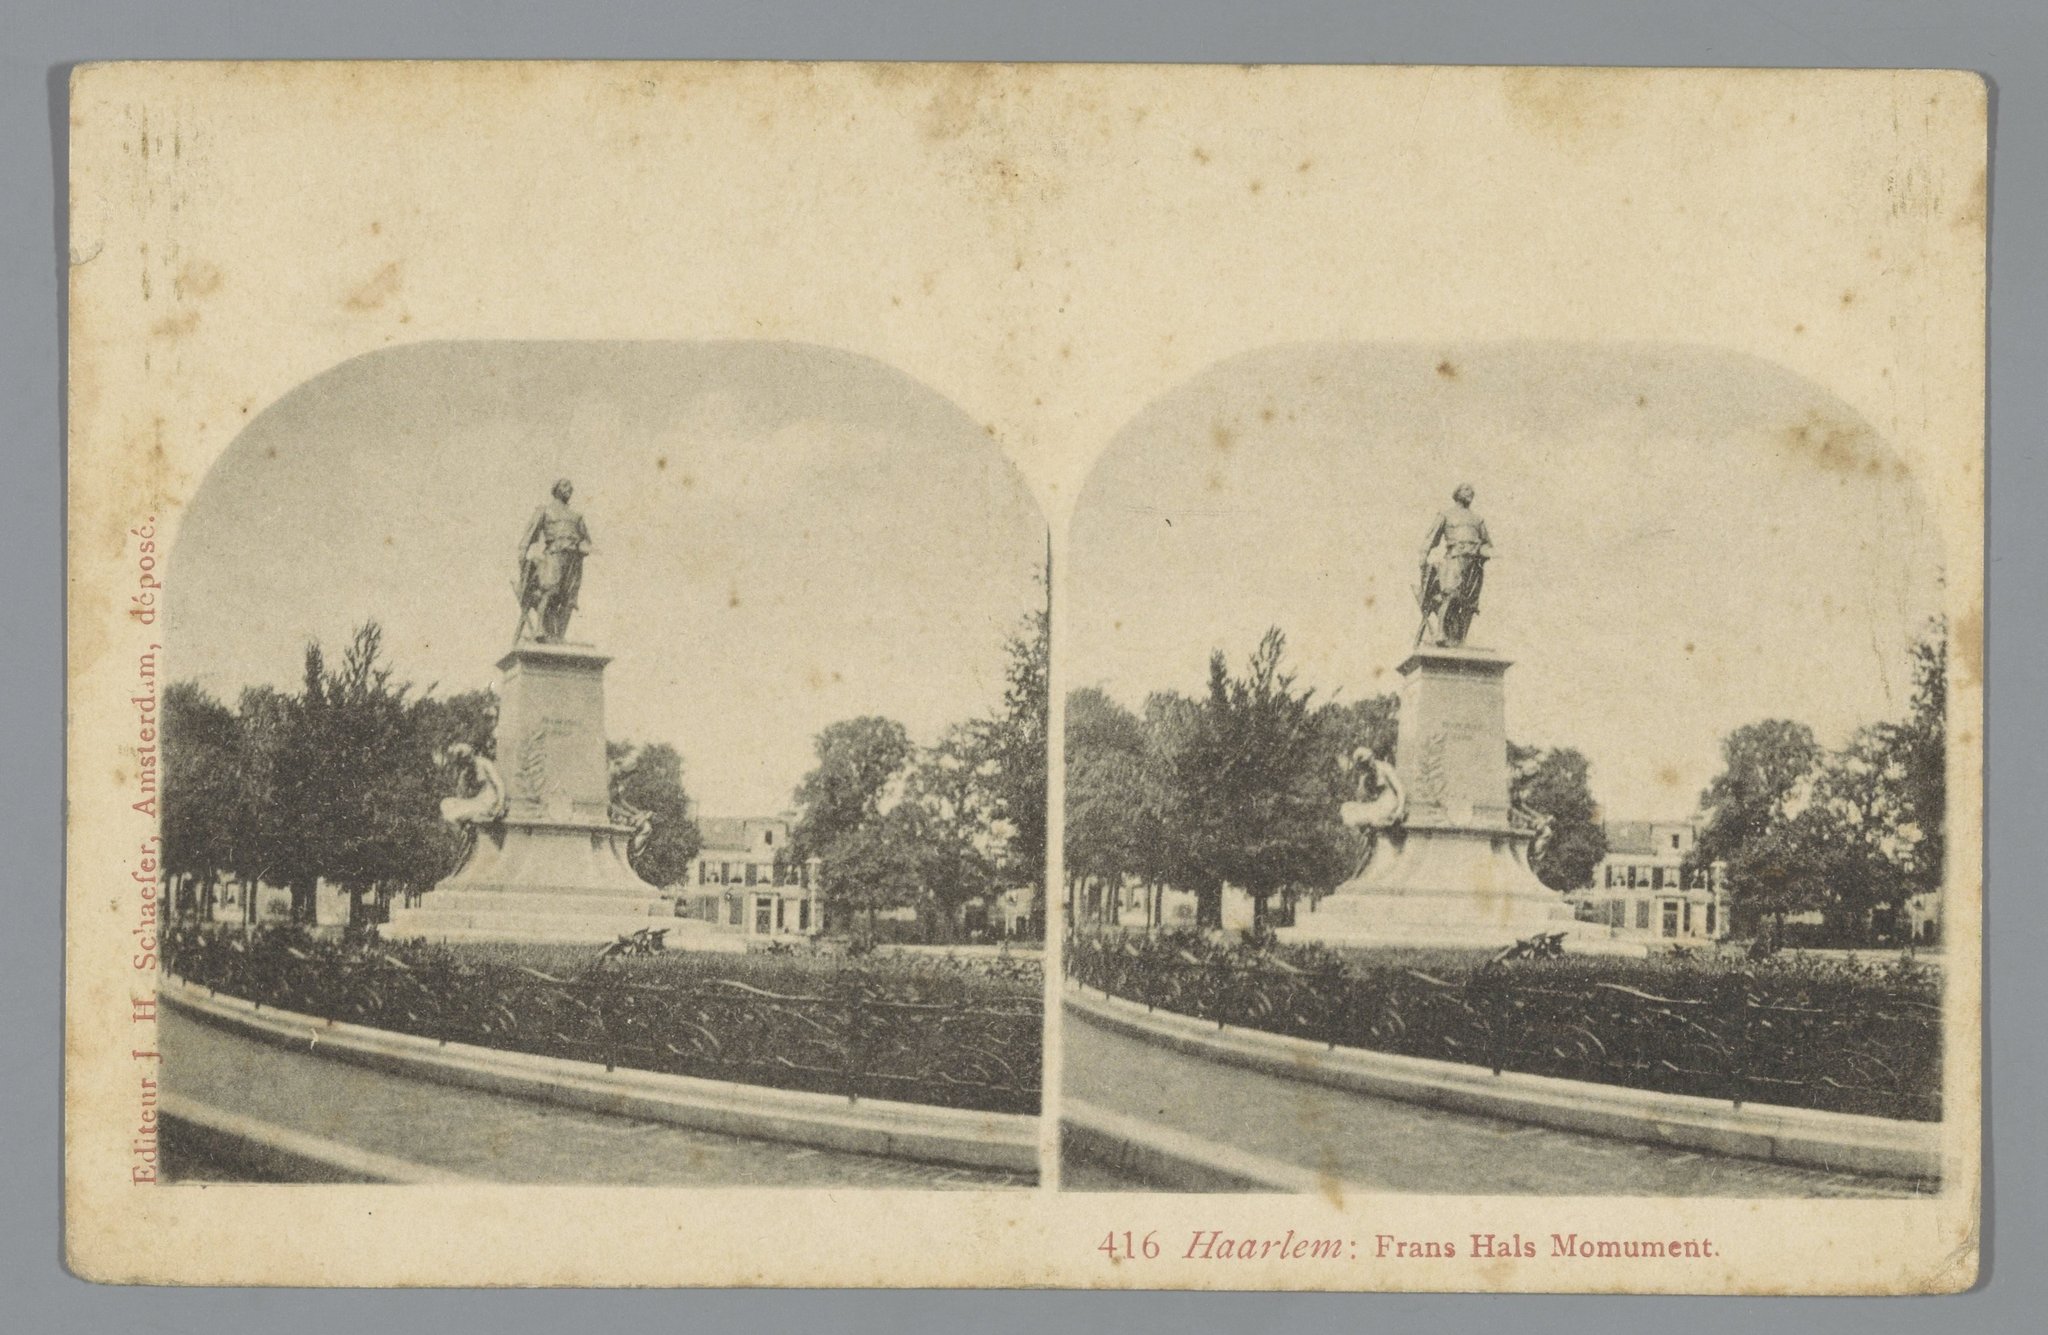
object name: ansichtkaart, prentbriefkaart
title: Haarlem: Frans Hals Monument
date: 1896-1905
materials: cardboard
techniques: photograph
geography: amsterdam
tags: antwerp, draughtsman, frans hals, monument, statue, haarlem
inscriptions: number: ‘1,-’, inscription: ‘Briefkaart/ Aan...’, number: ‘416’